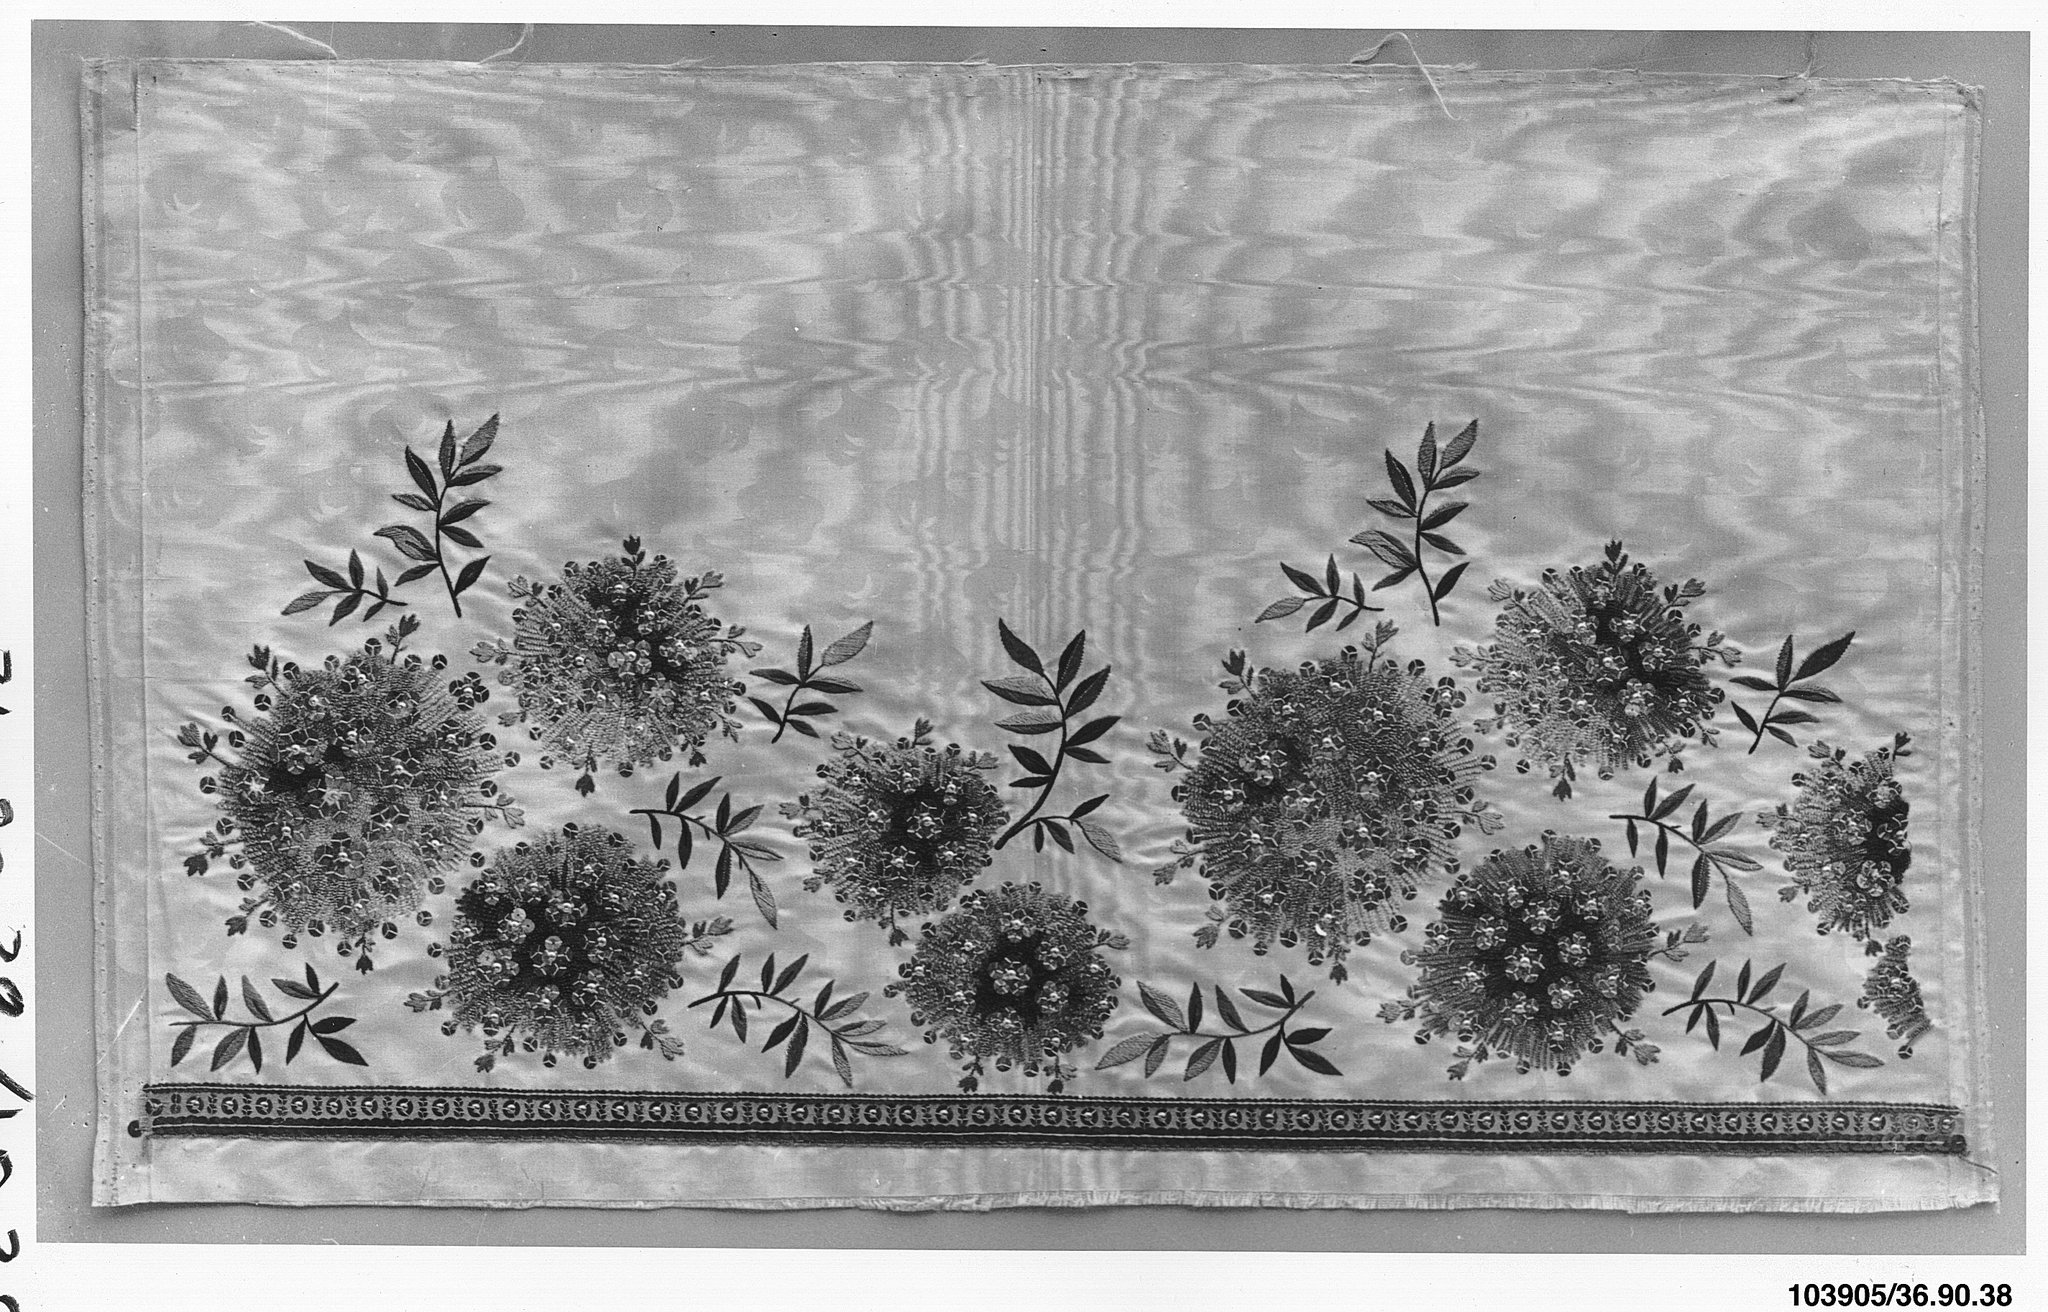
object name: border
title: Dress border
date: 1805-1815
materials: metal thread, silk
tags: flowers